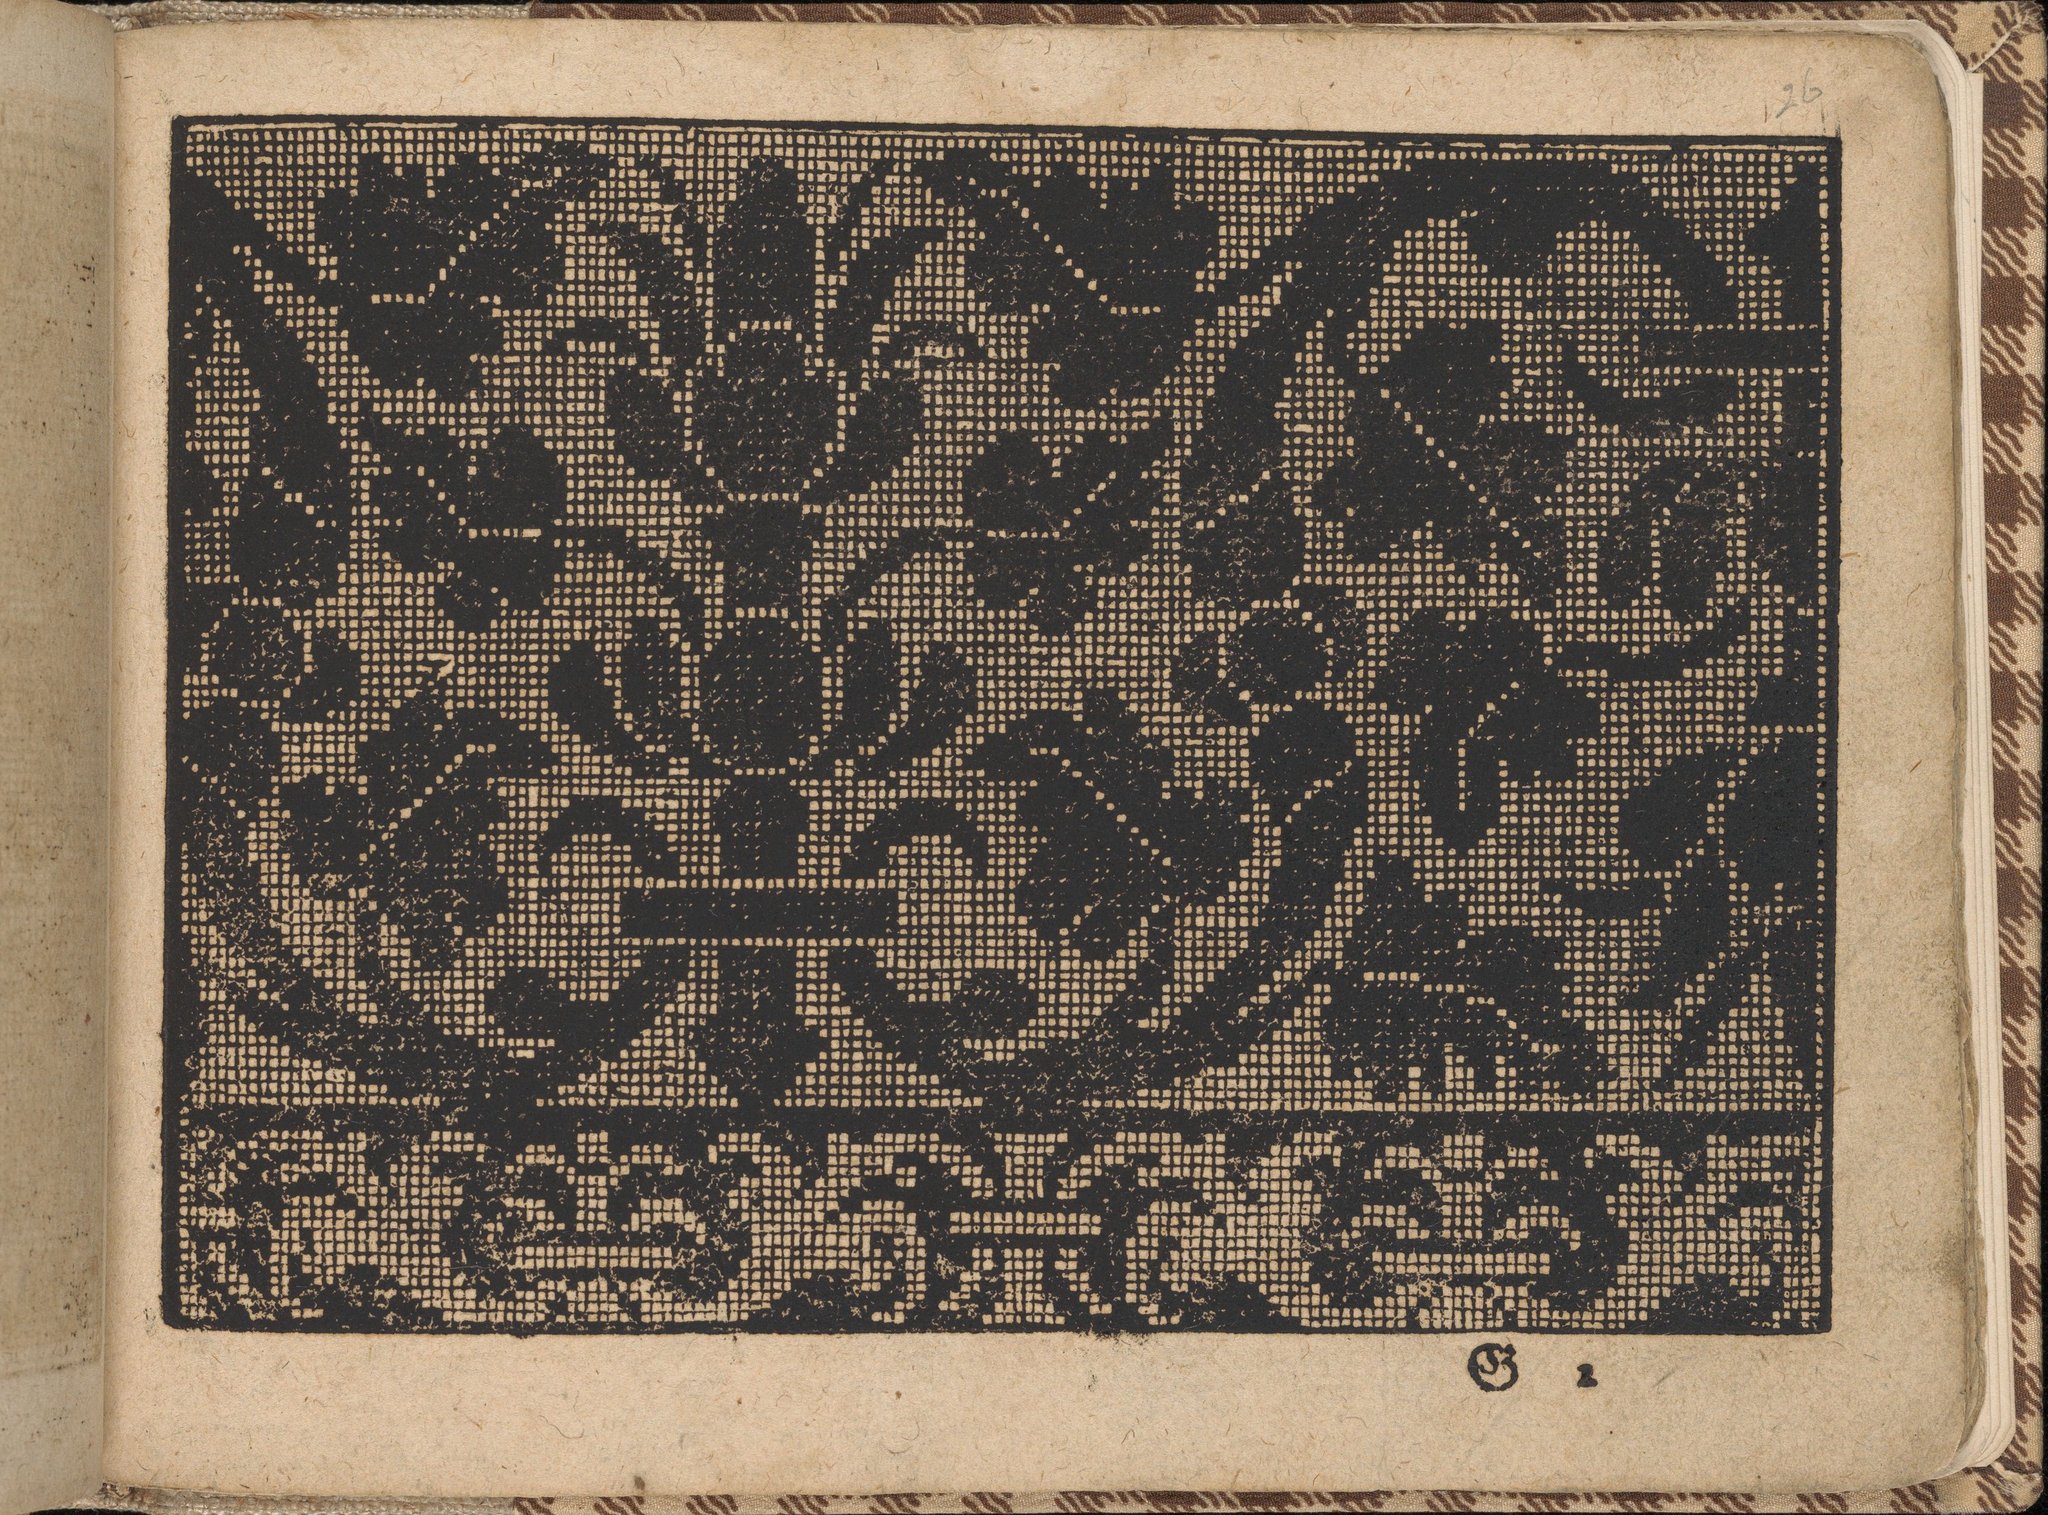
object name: book print ornament architecture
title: New Künstlichs Modelbuch (Page 26 recto)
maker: bernhard jobin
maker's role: publisher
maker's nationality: swiss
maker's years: 1535-1597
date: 1600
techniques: woodcut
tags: flowers